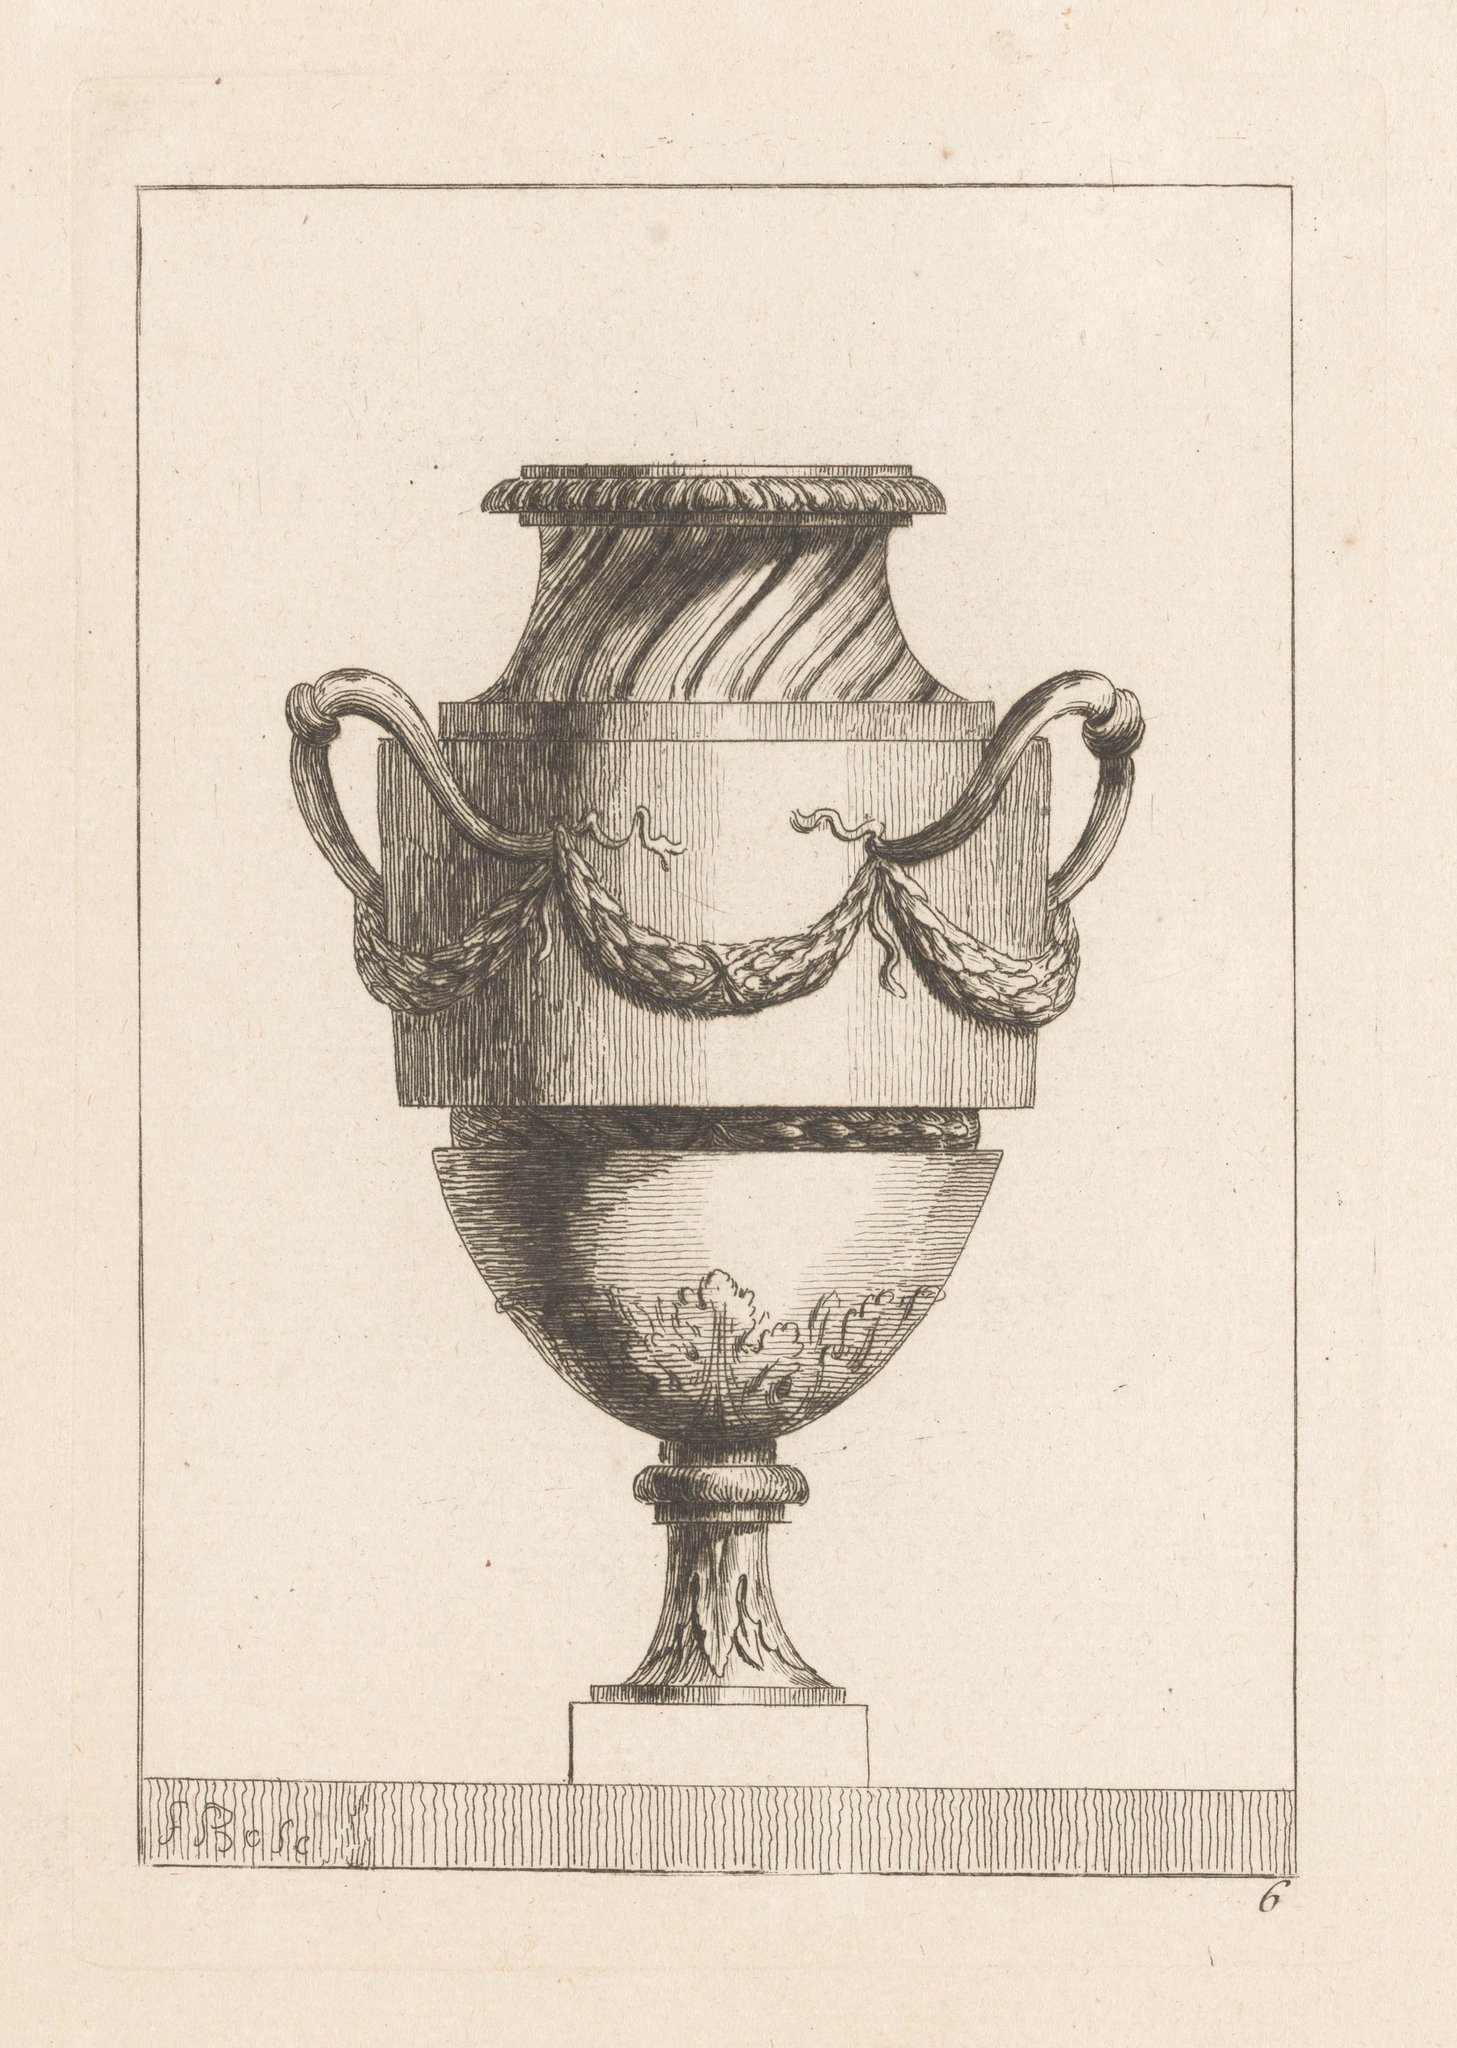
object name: ornament print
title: Vaas met guirlandes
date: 1755-1782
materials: paper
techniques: etching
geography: paris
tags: vase ~ ornament, ornament ~ festoon, garland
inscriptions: collector's mark: Lugt 2760, collector's mark: Lugt 2228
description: Een vaas met guirlandes op de buik en twee handvaten.